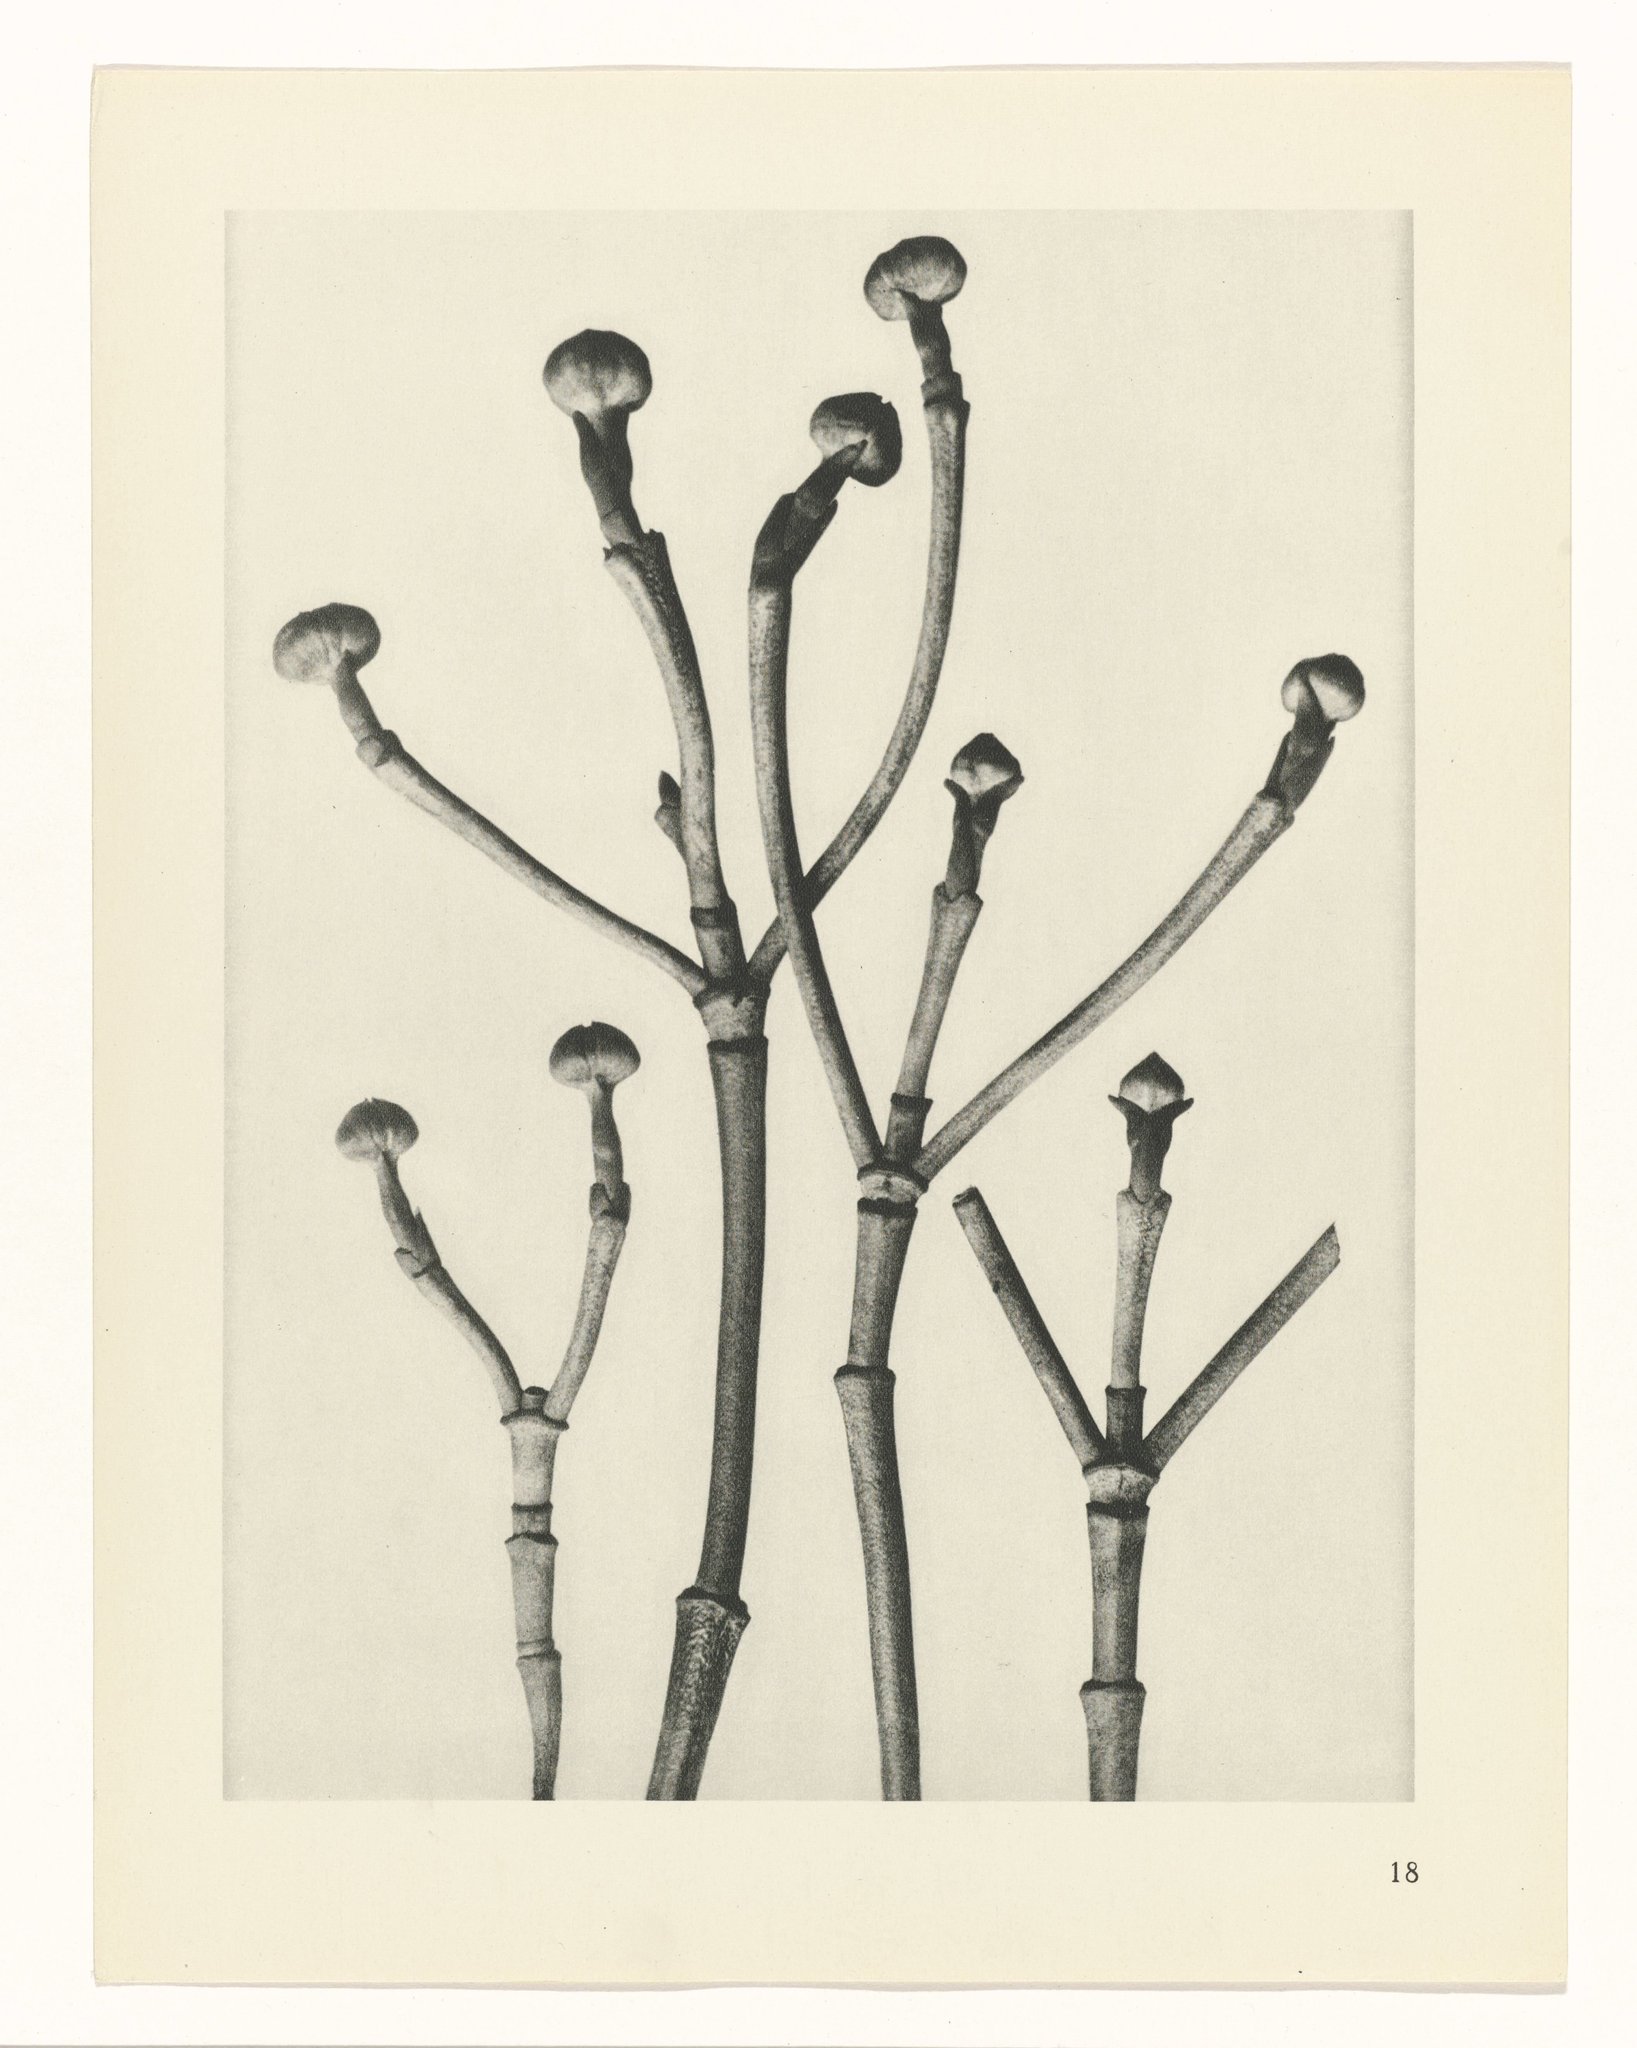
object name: photograph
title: Plant Studies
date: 1928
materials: ink, paper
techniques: rotogravure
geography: berlin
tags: plants (in general)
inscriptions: number: ‘18’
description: facher Vergrößerung. Afkomstig uit losbladige uitgave.